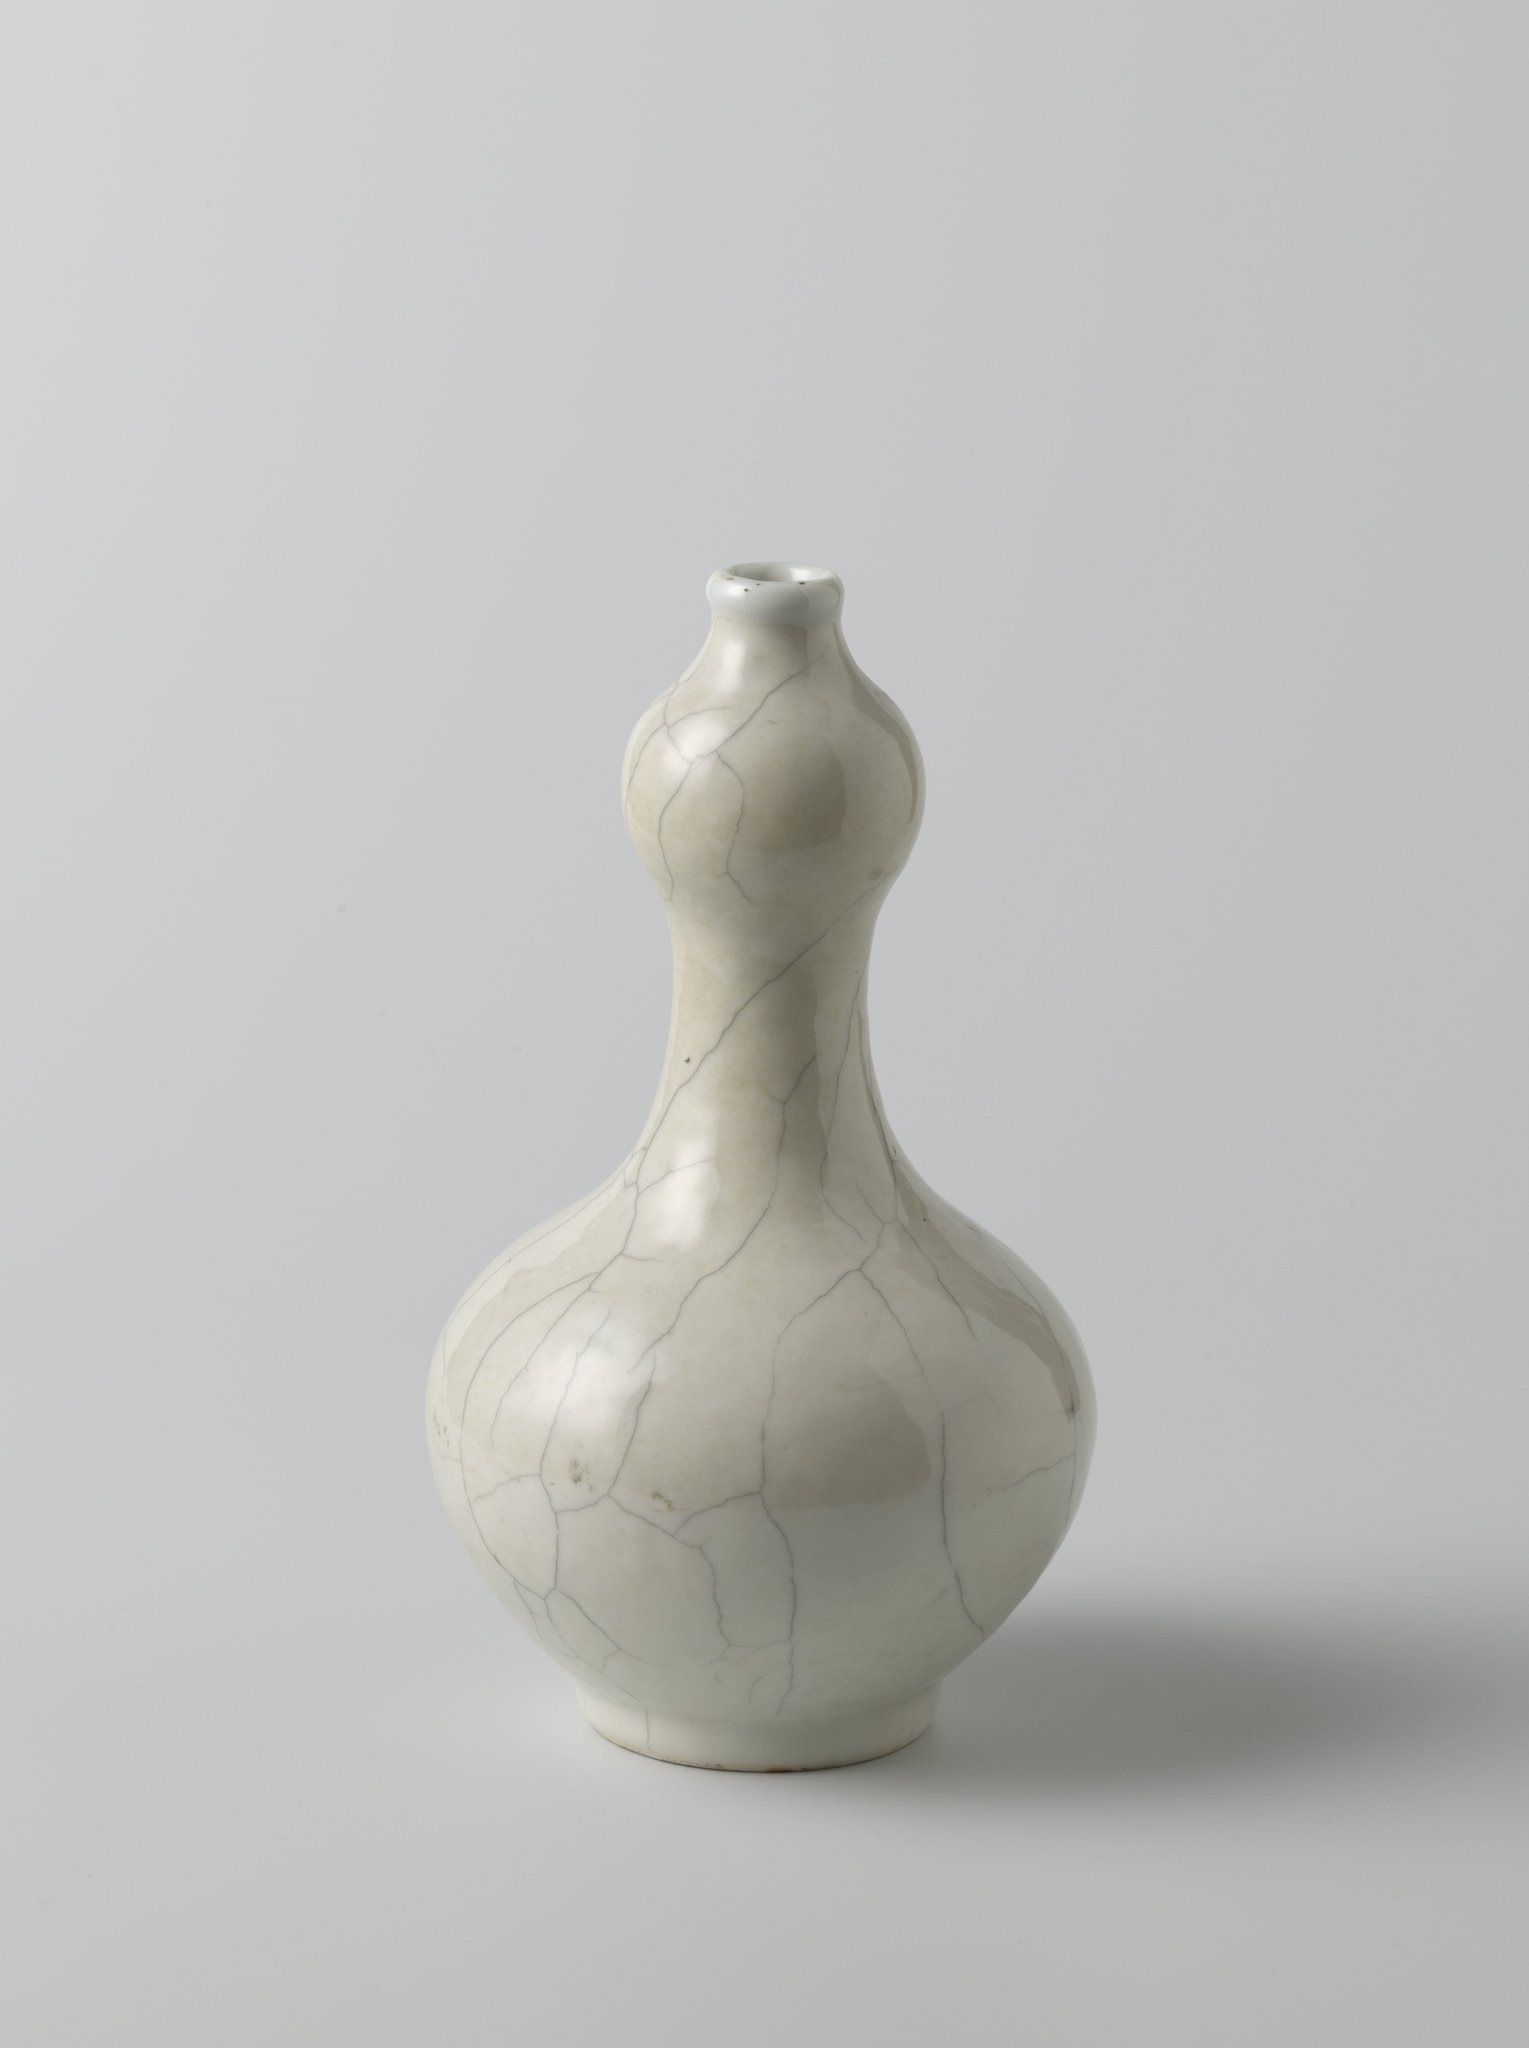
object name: vase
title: Pear-shaped bottle vase with a crackled glaze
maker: Anonymous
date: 1800-1899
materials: glaze, porcelain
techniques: firing, turning, vitrification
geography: dehua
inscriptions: label: ‘B. 206b’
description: Flesvormige vaas van porselein met peervormige lichaam en verdikking in de nek, bedekt met een doorschijnend wit glazuur. Gecraqueleerd glazuur. Oud label op de onderzijde met 'B. 206b'. Monochromen.